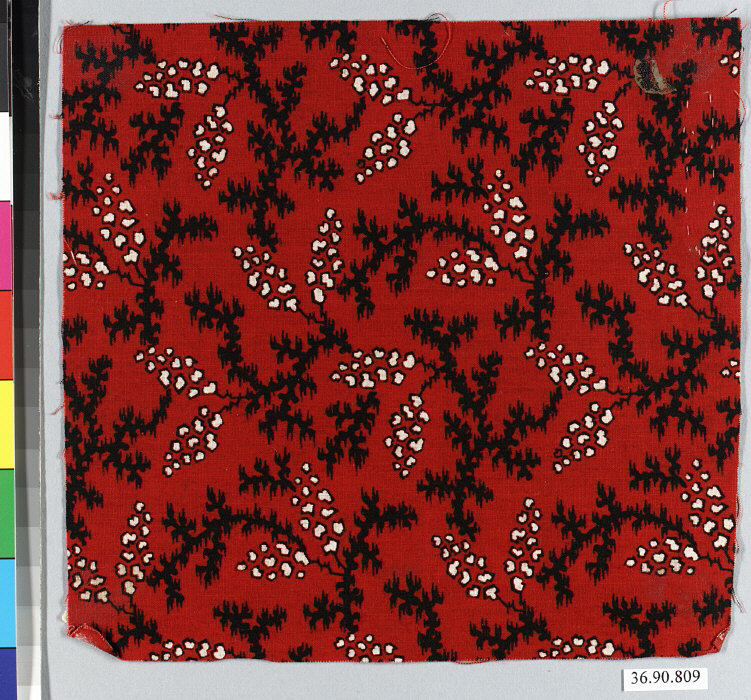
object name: piece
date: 1867-1900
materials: cotton